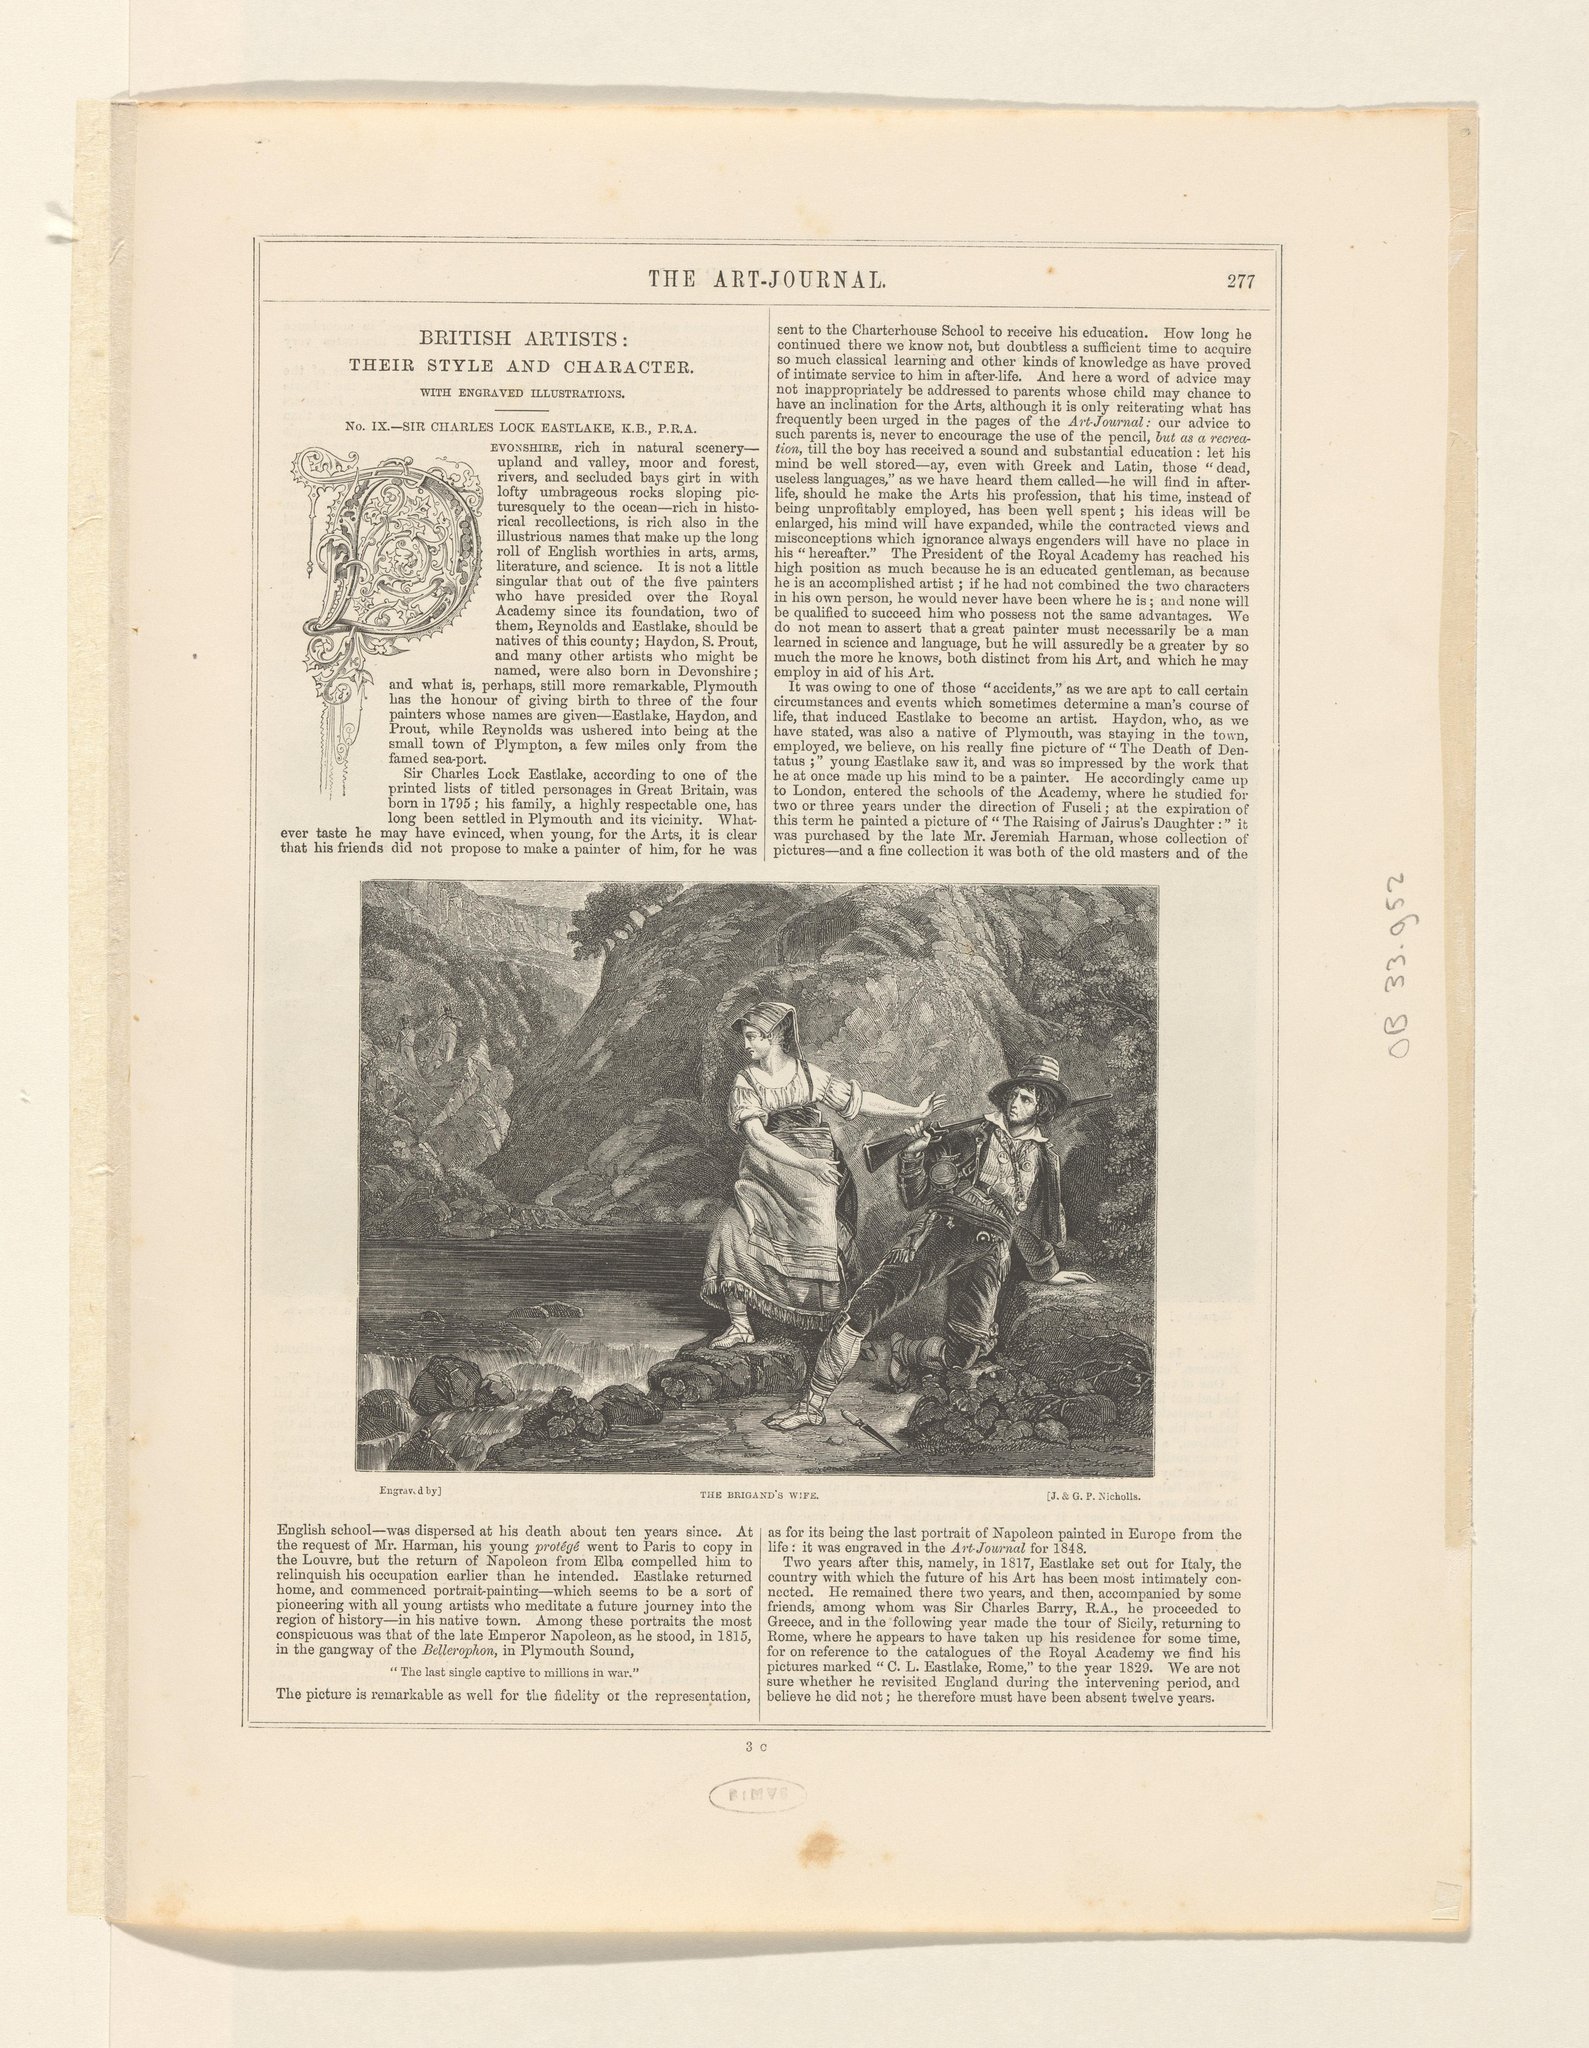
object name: print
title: The brigand's wife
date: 1855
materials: paper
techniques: letterpress printing, engraving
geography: london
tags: marriage, married couple, 'matrimonium', waterfall (+ landscape with figures, staffage)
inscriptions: collector's mark: Lugt 2228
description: Prent uit: The Art Journal (1855), 1855, p. 277.